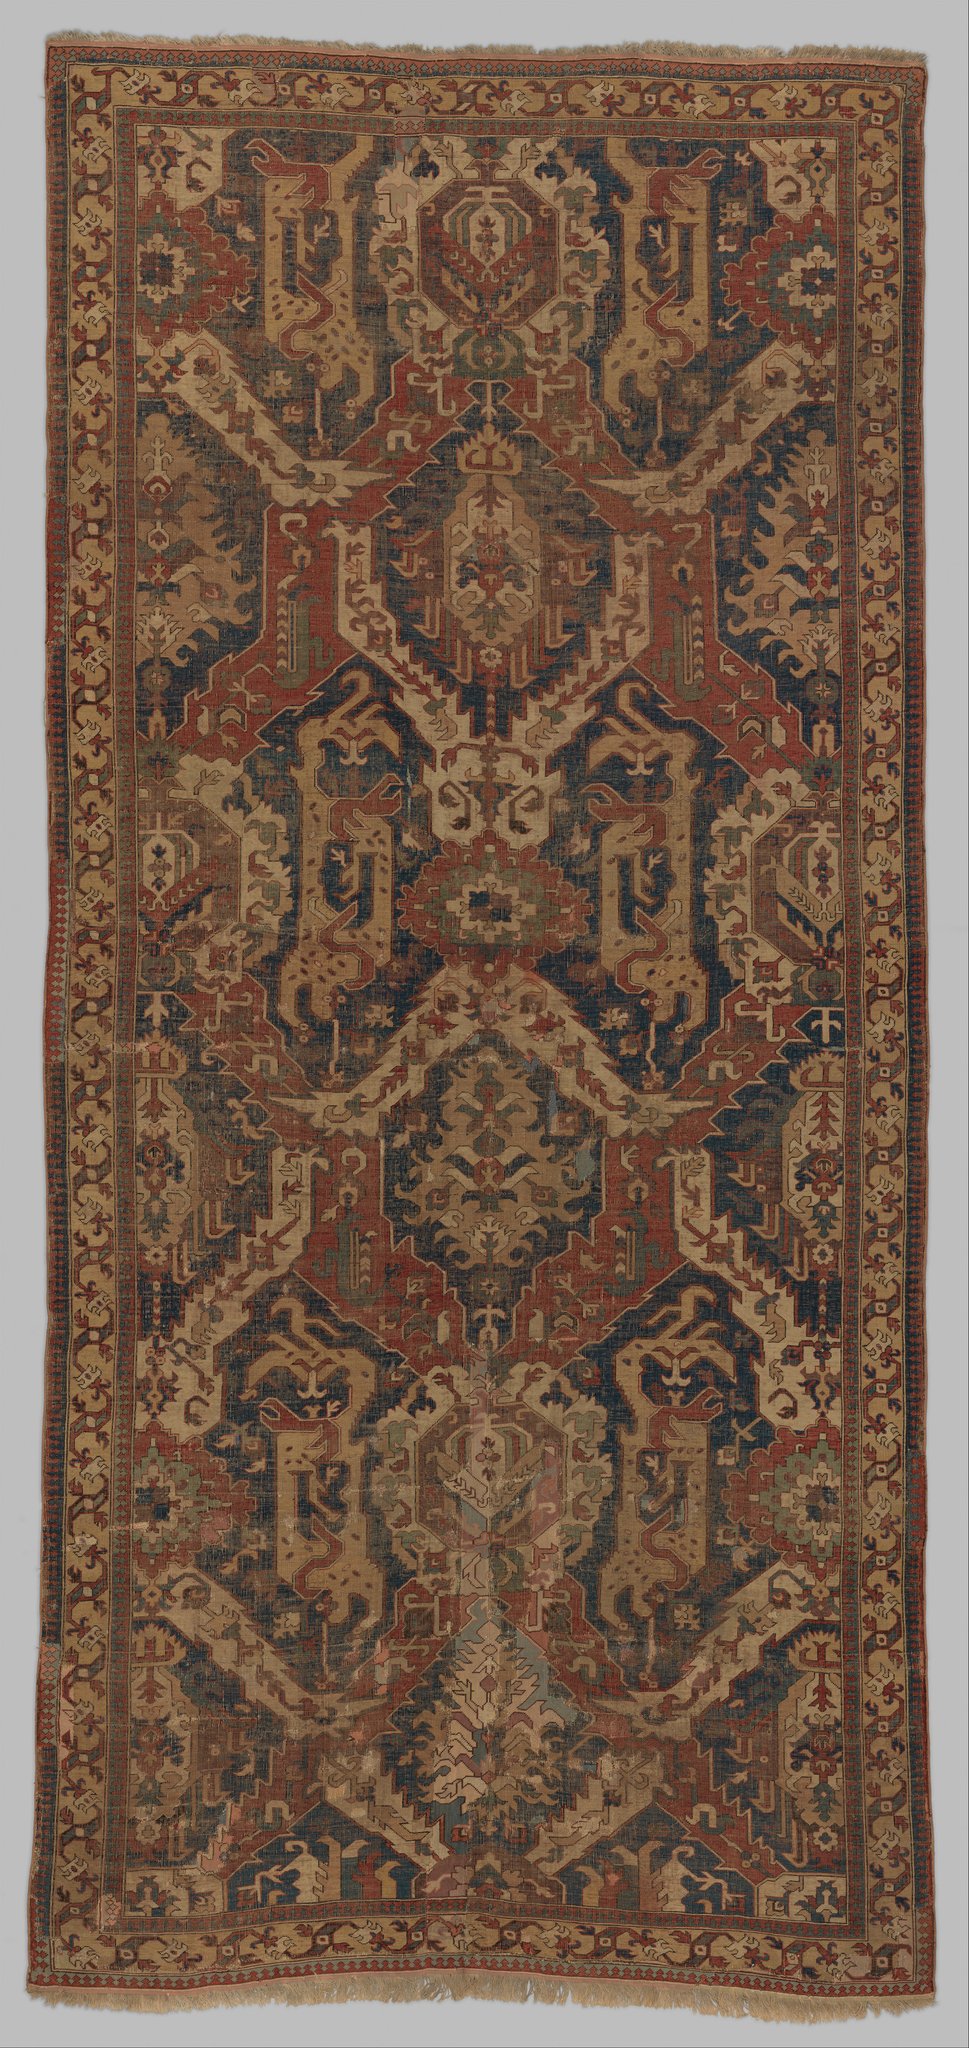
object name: carpet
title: Dragon Carpet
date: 1601-1700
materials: wool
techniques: pile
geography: azerbaijan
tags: dragons